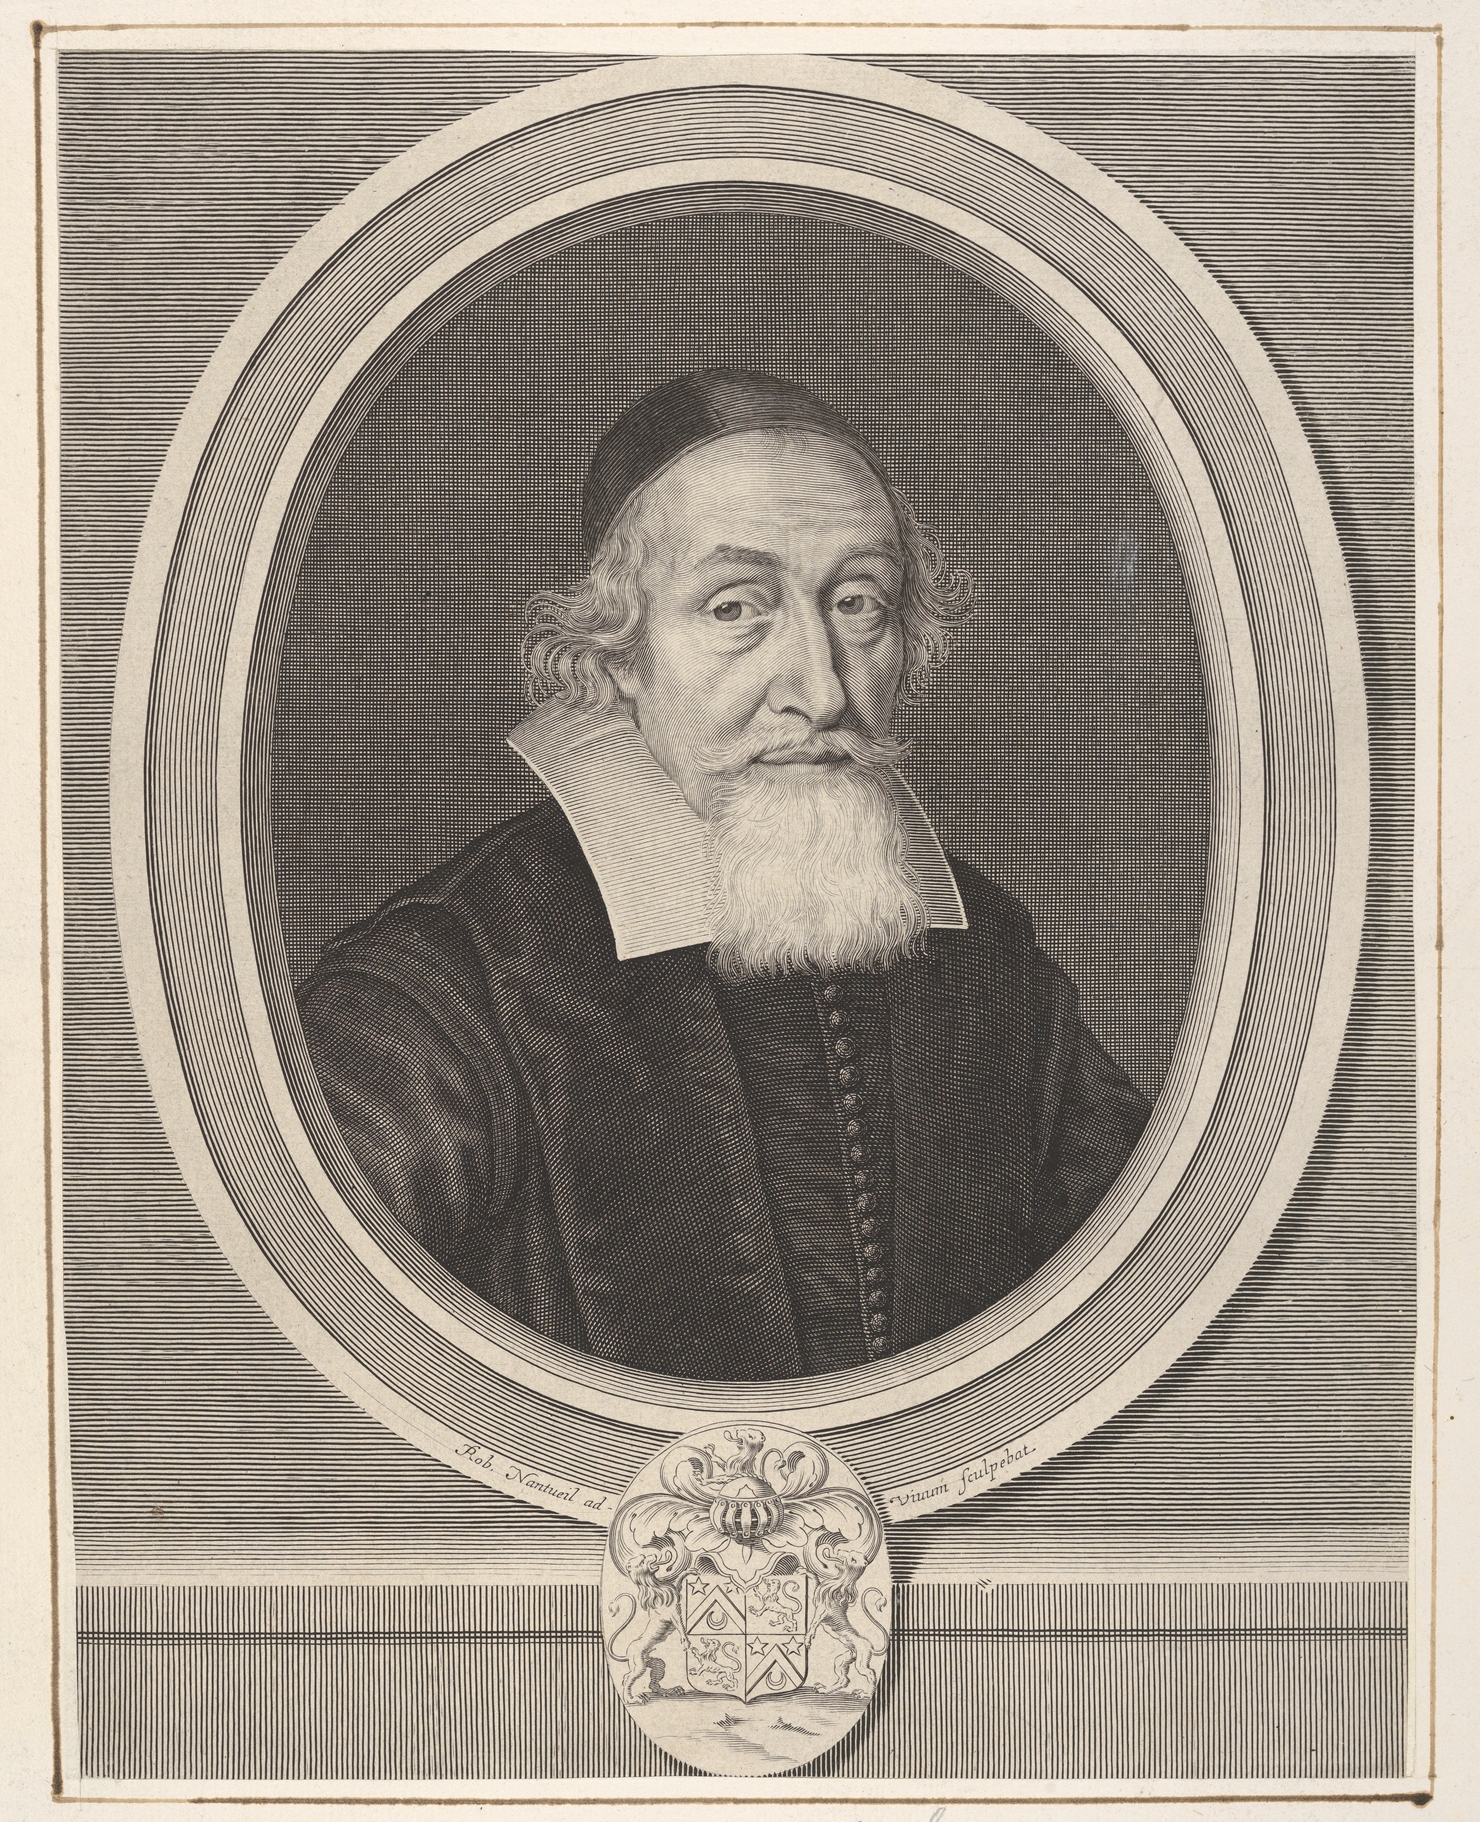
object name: print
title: Mathieu Molé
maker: robert nanteuil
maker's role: artist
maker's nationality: french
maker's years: 1623-1678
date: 1653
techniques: engraving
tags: men,portraits,coat of arms